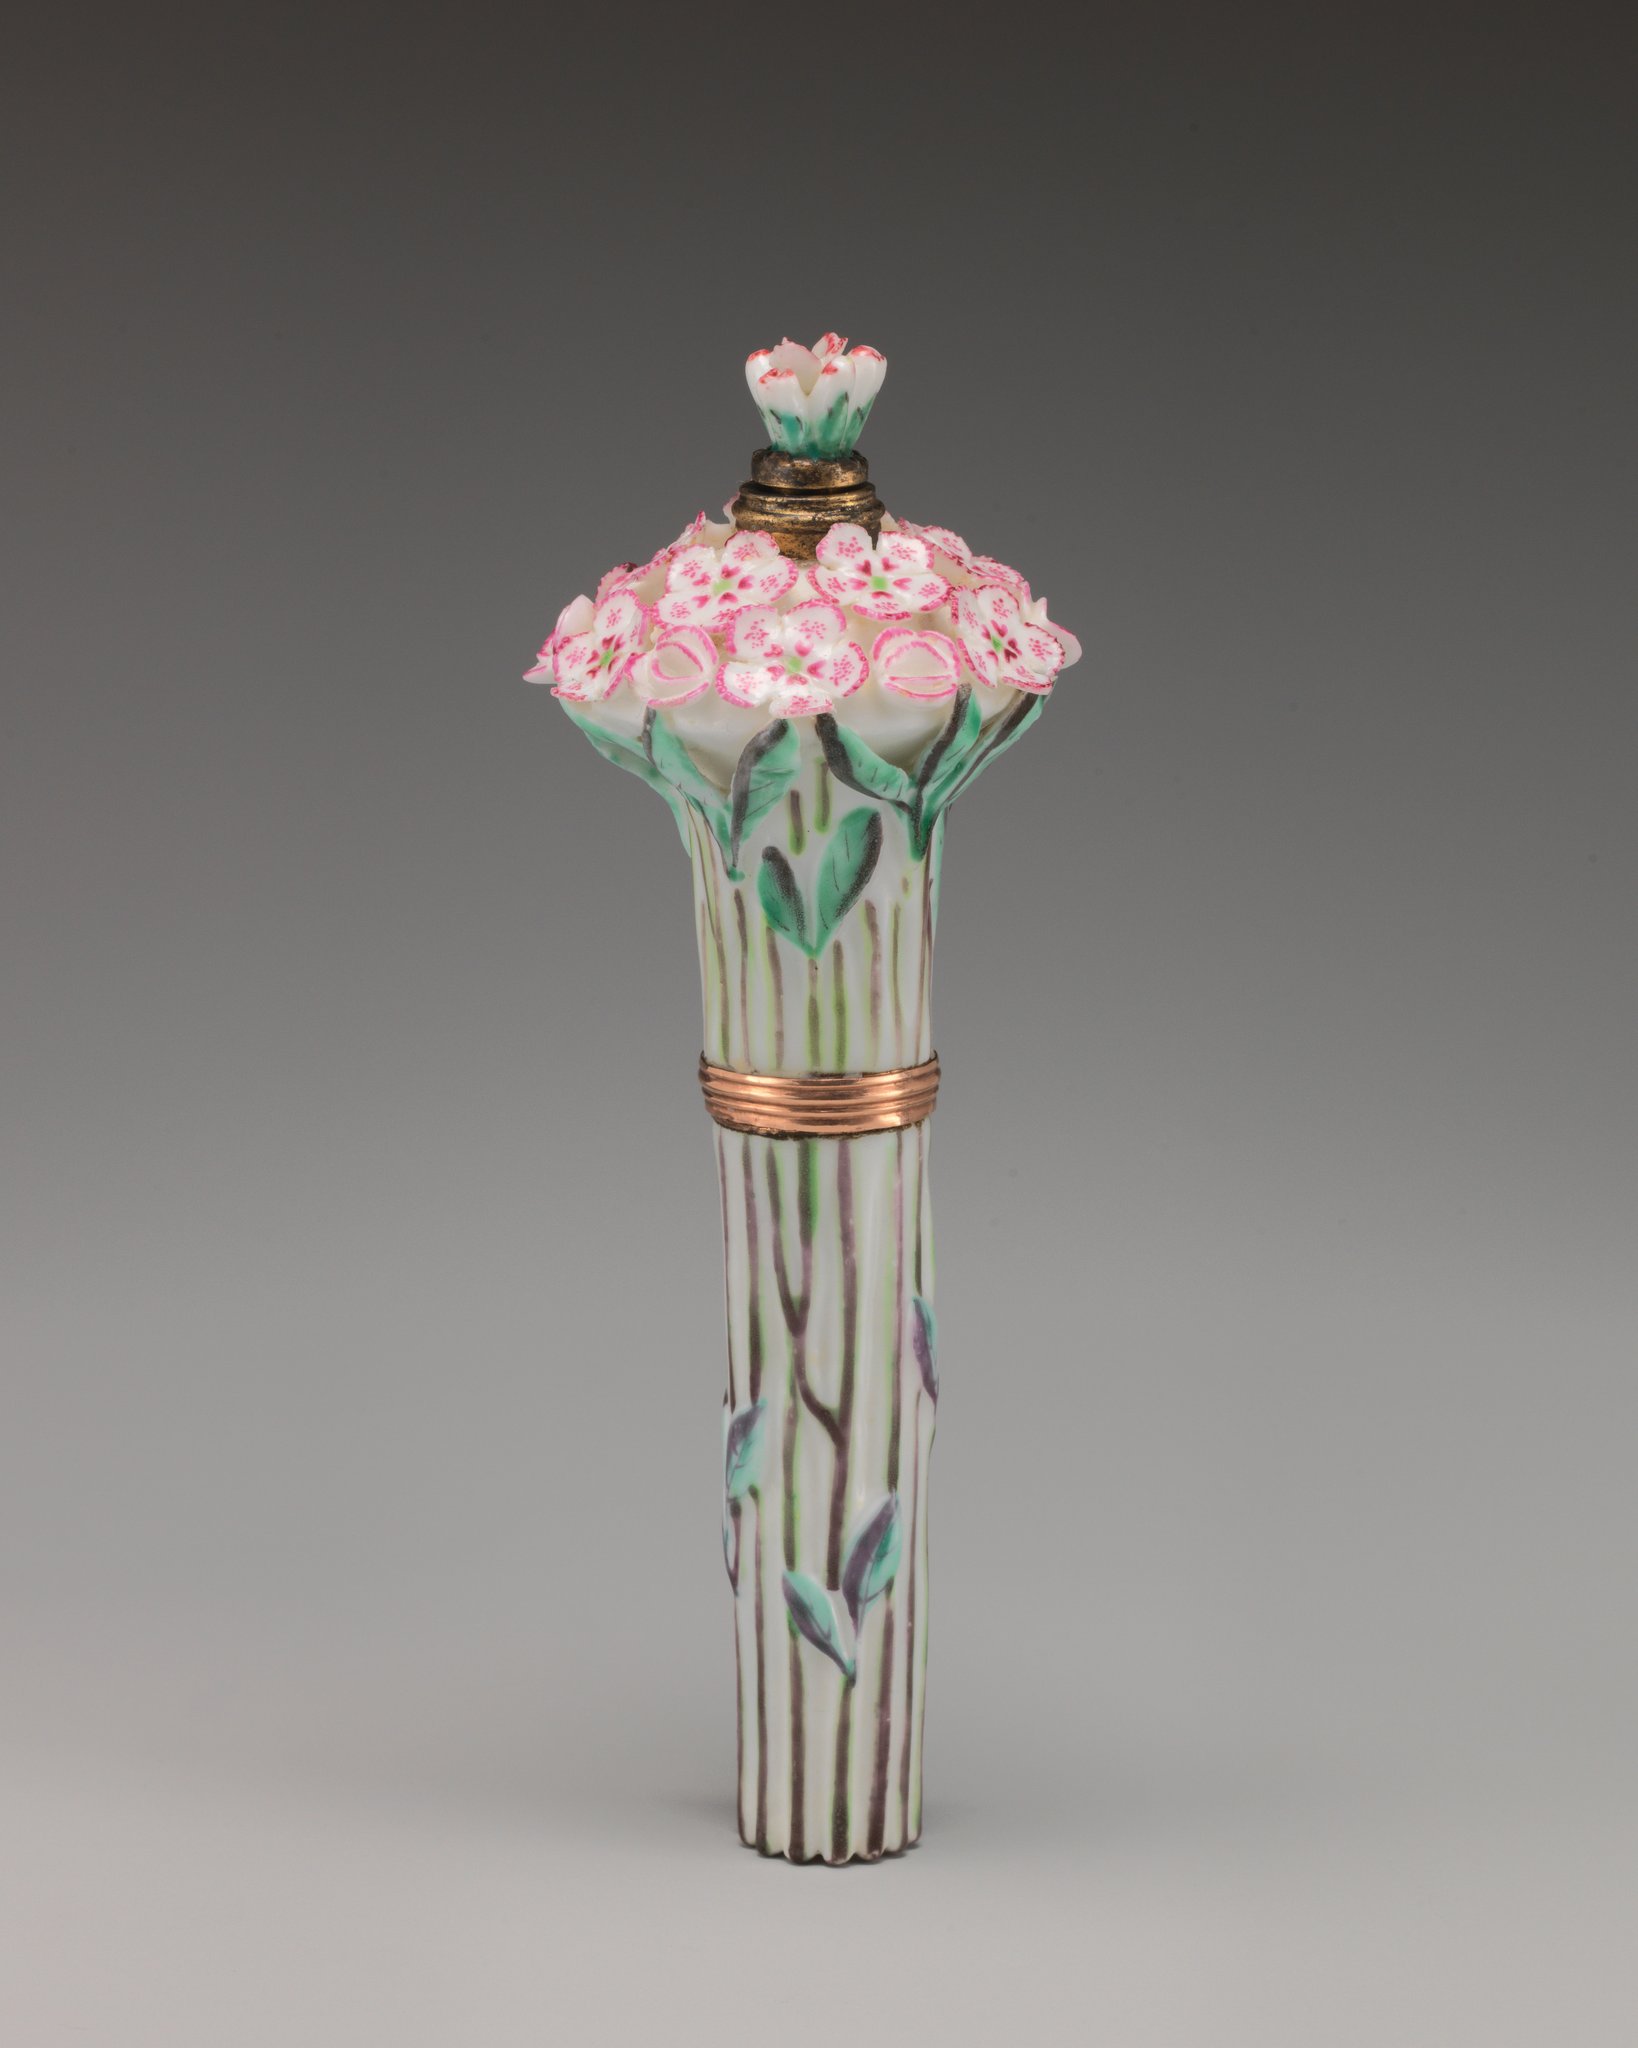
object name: toy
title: Nosegay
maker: saint james's factory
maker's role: maker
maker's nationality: british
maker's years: 1749-1759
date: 1750-1755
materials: soft paste porcelain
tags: flowers